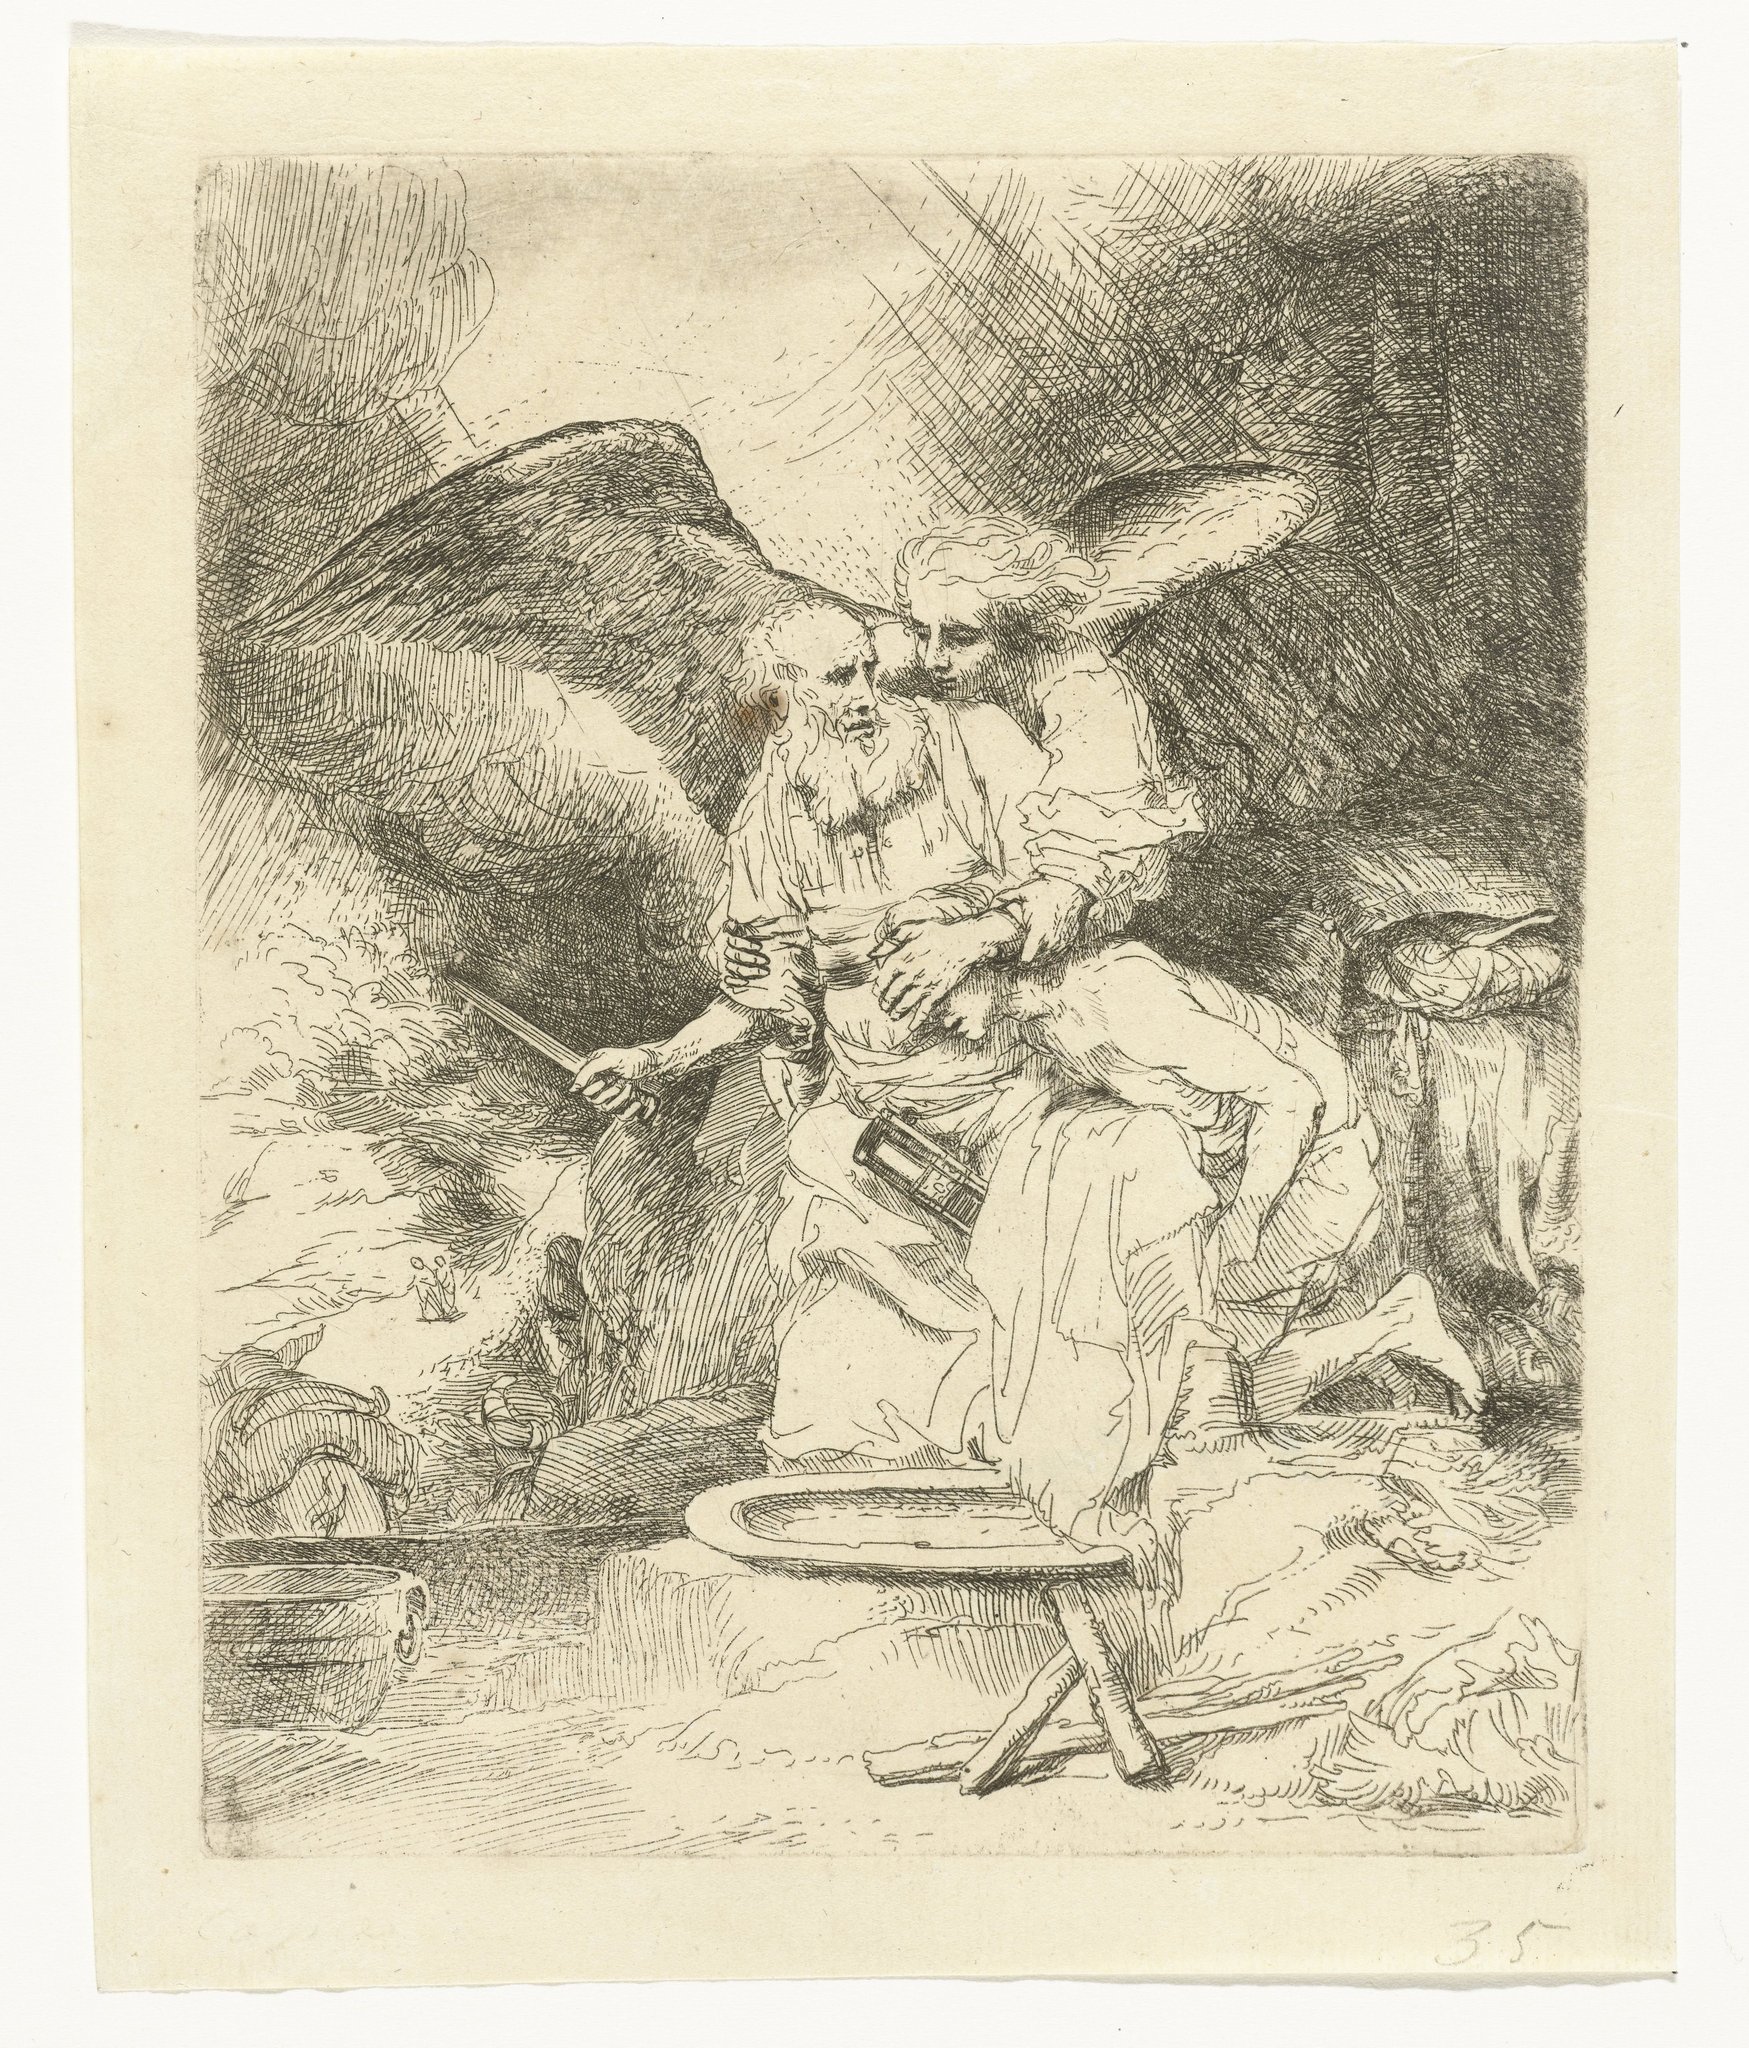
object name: print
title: Abraham's sacrifice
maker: Anonymous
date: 1655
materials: paper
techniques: etching, intaglio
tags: the sacrifice of isaac (genesis 22)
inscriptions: collector's mark: Lugt 2228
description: Spiegelbeeldige kopie naar de gelijknamige prent van Rembrandt.